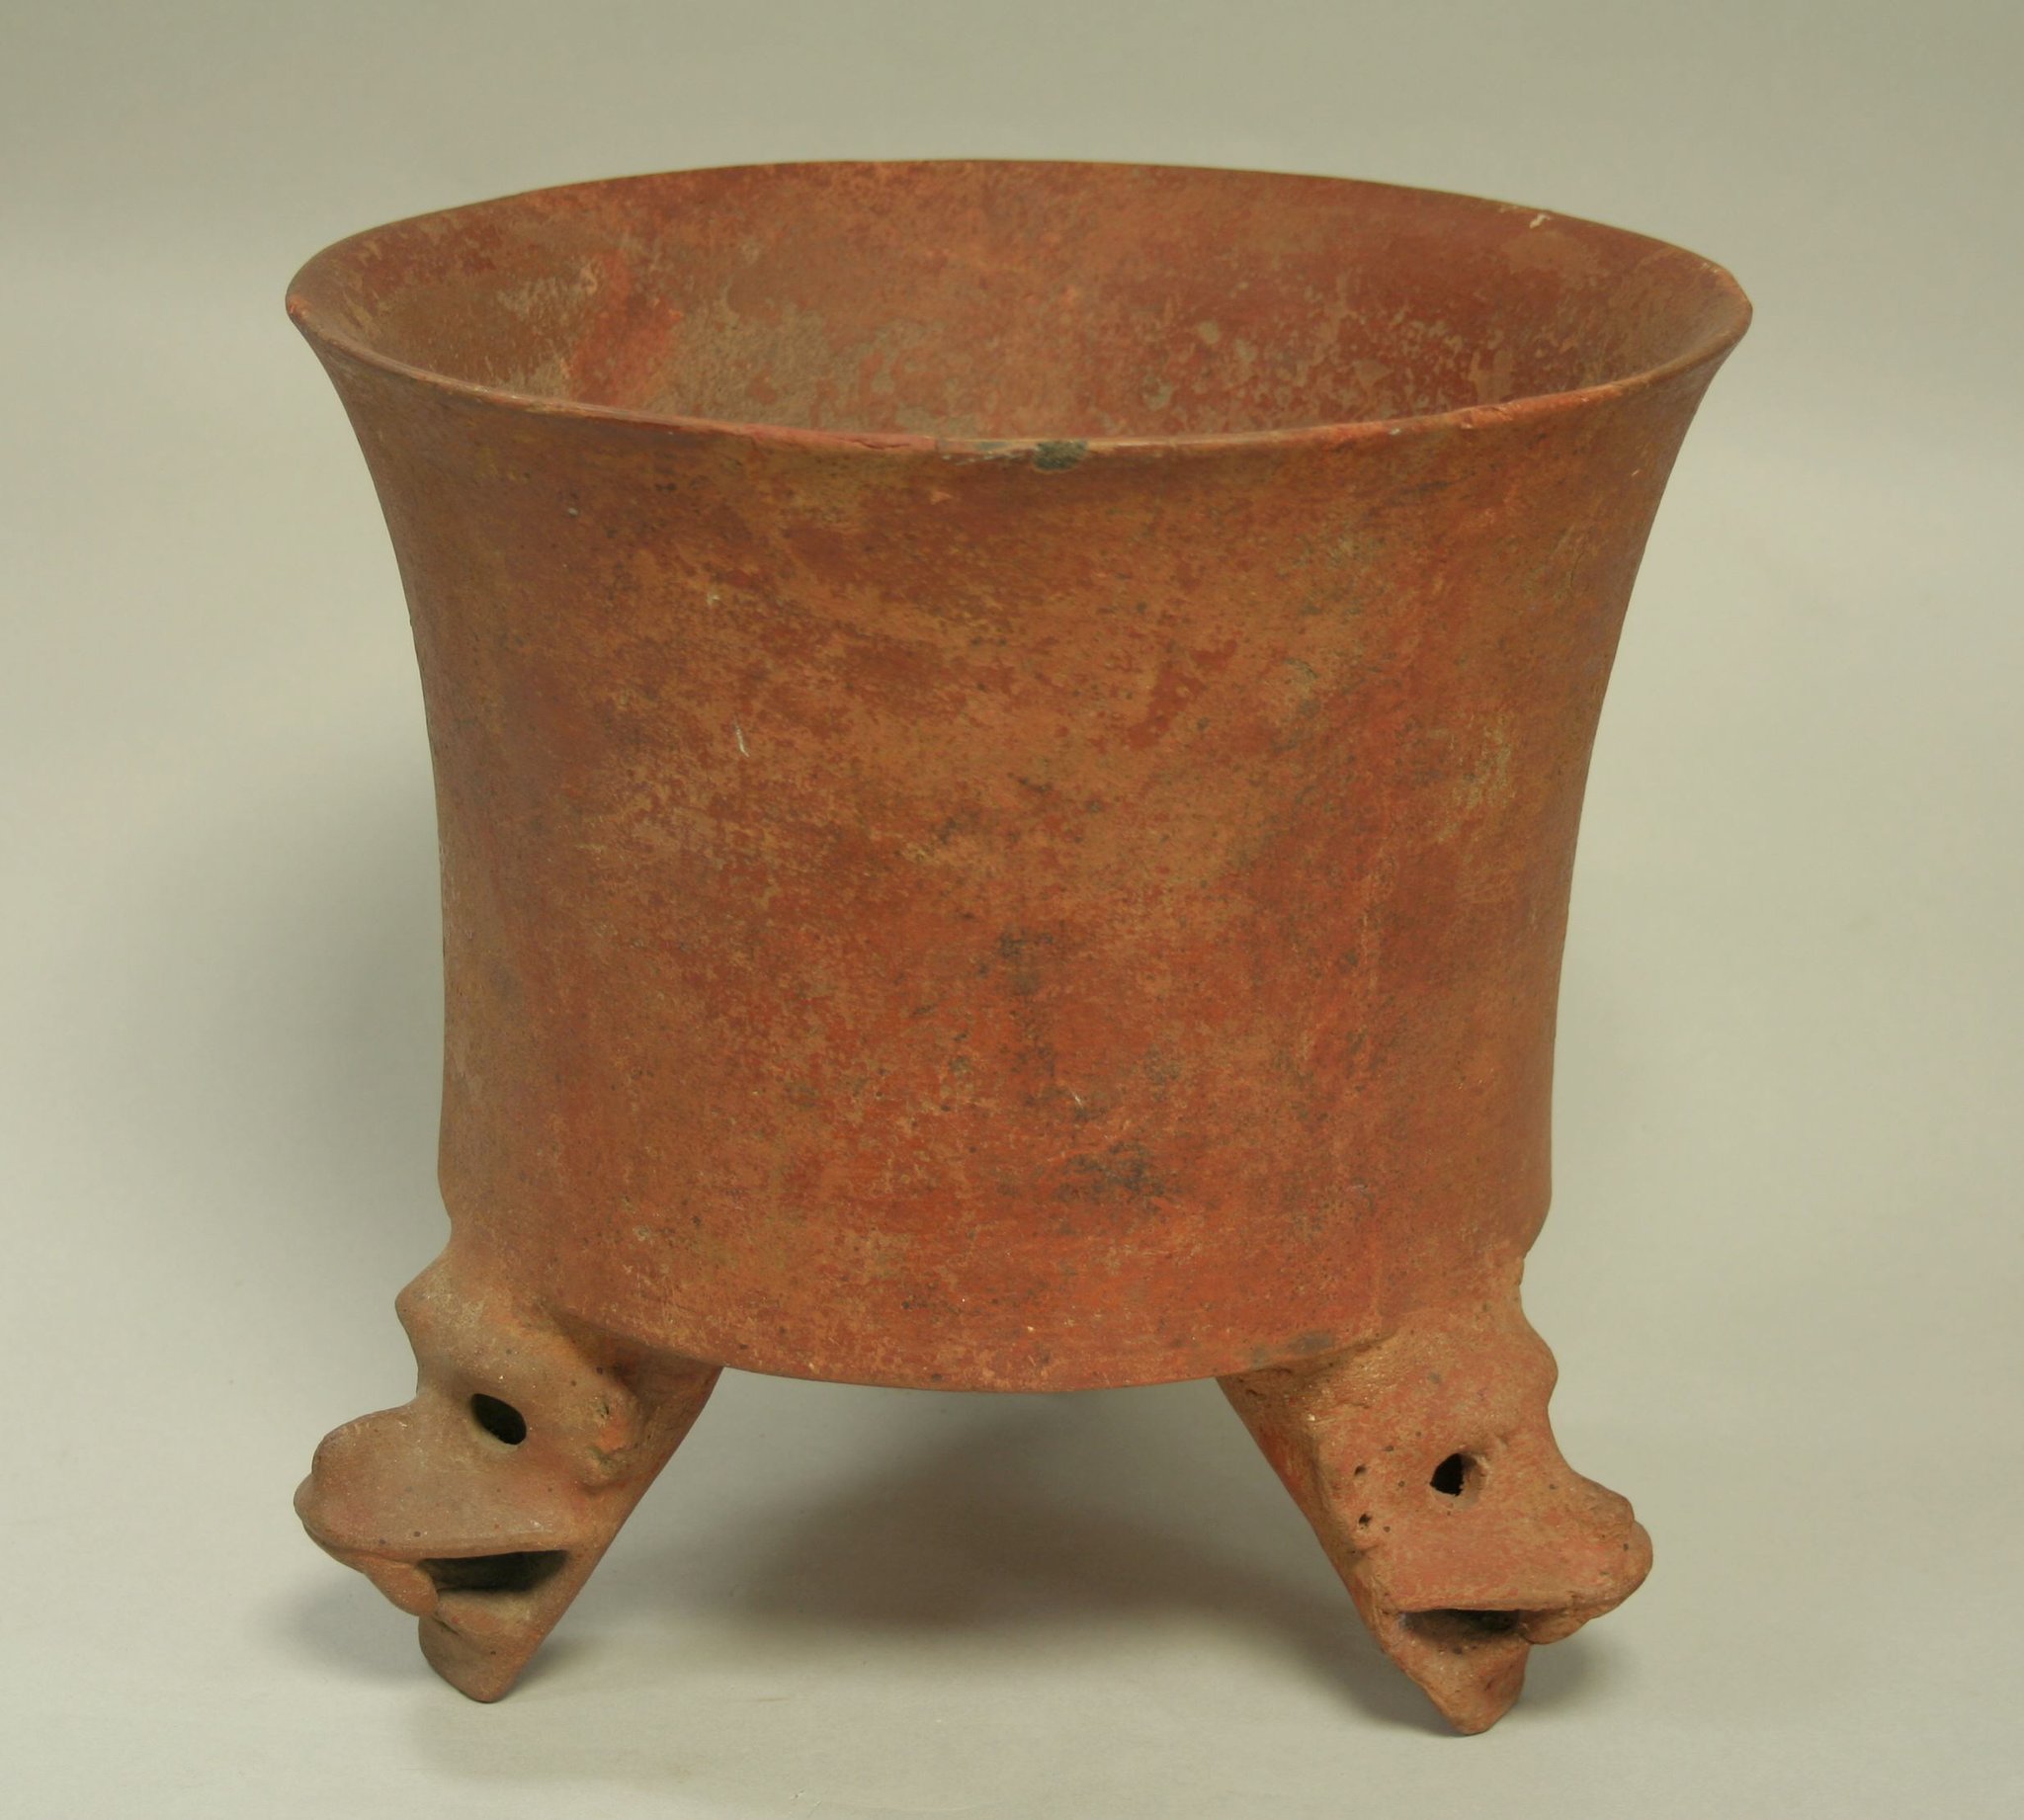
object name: vessel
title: Tripod Vessel with Jaguar Head Feet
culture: costa rican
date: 801-1500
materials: ceramic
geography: costa rica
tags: animals